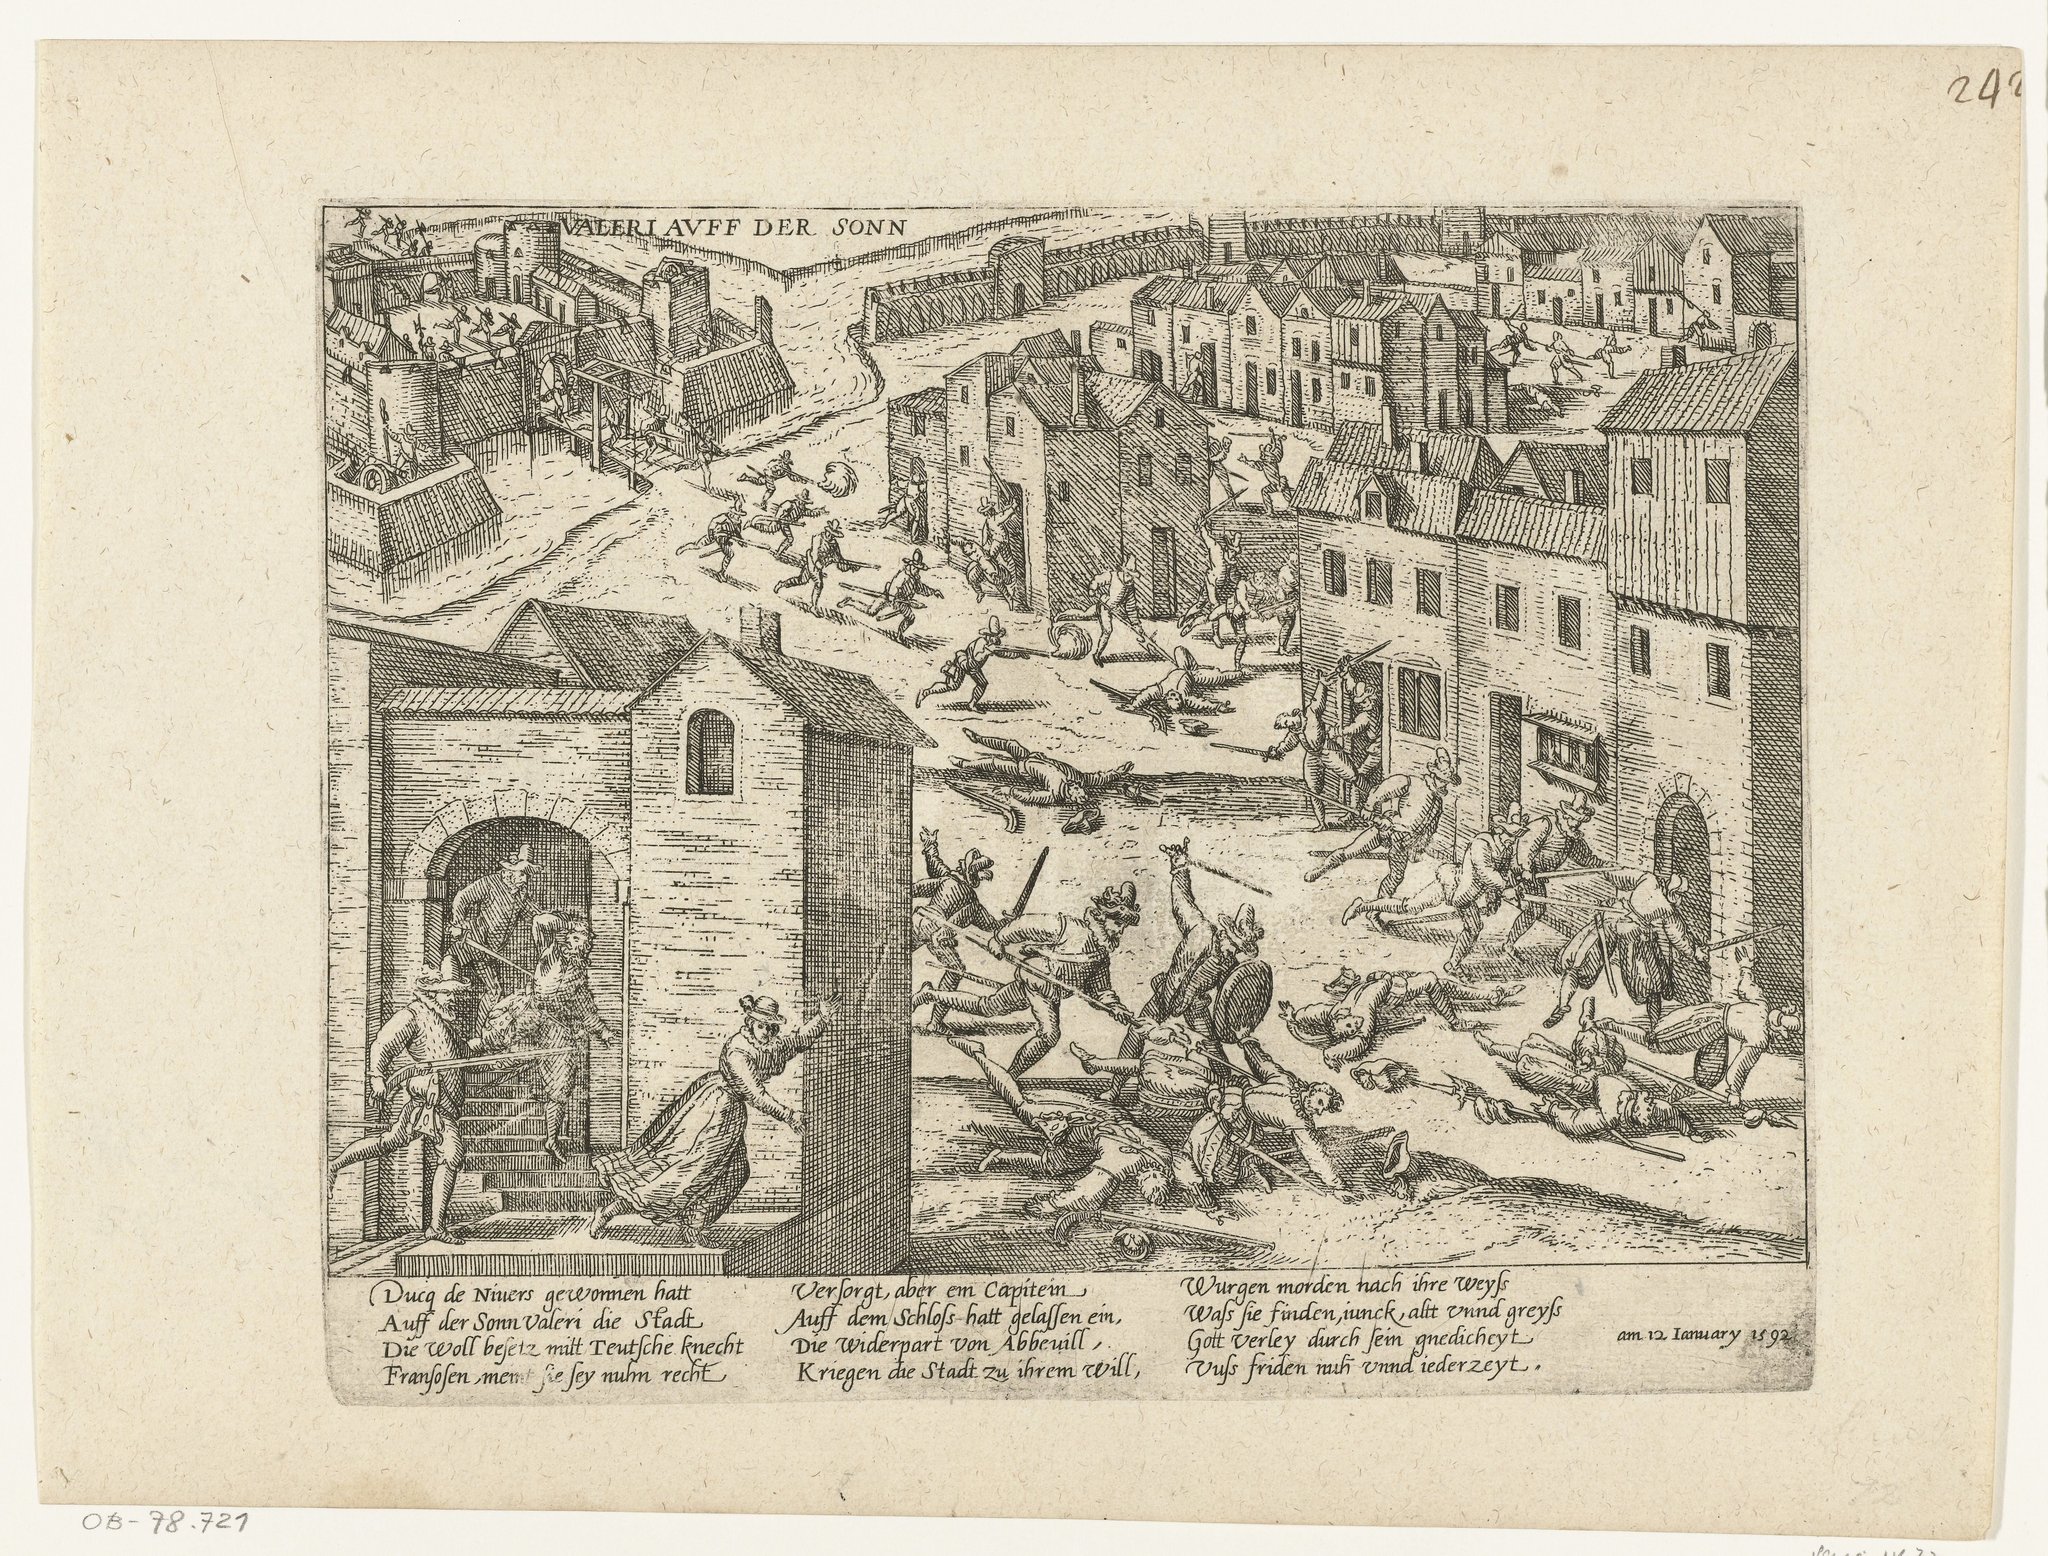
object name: print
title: Overval op Saint-Valery-sur-Somme, 1592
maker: frans hogenberg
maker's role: print maker, publisher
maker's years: 1538-1590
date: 1592-1594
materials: paper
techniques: etching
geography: cologne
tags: massacre ~ war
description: Overval op Saint-Valery-sur-Somme, 12 januari 1592. Soldaten doden burgers in de starten van de stad. Met onderschrift van 12 regels in het Duits. Ongenummerd. Blad afkomstig uit een album dat uit elkaar is gehaald. Rechtsboven genummerd (in pen): 242.